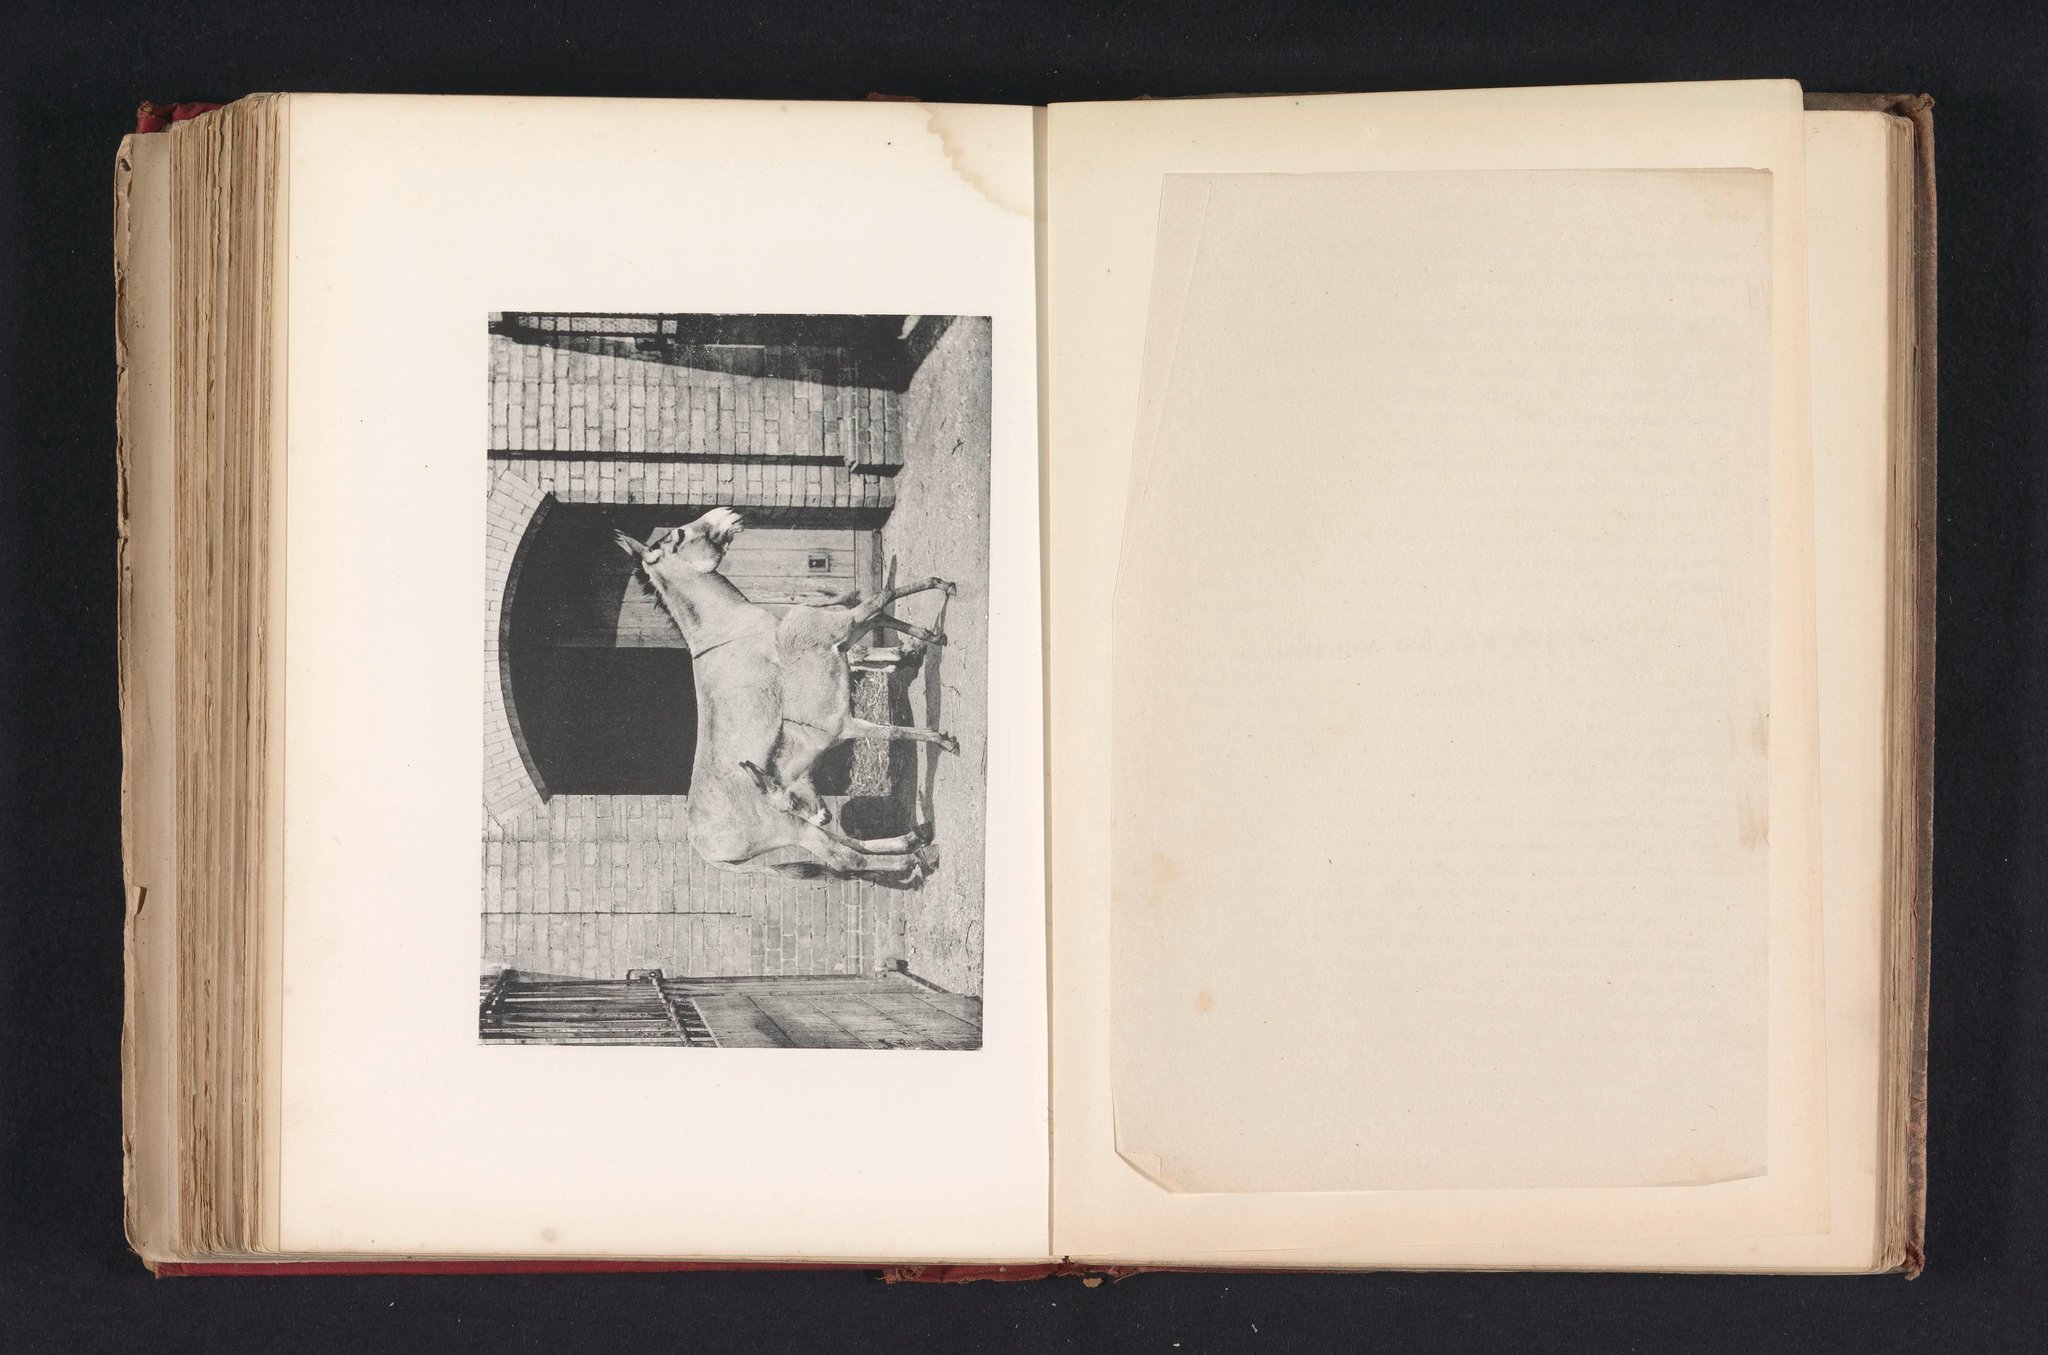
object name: photomechanical print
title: African wild ass and foal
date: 1876-1886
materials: paper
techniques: photograph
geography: paris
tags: ass, donkey, zoological garden, zoo, seen as place where non-domestic animals are kept